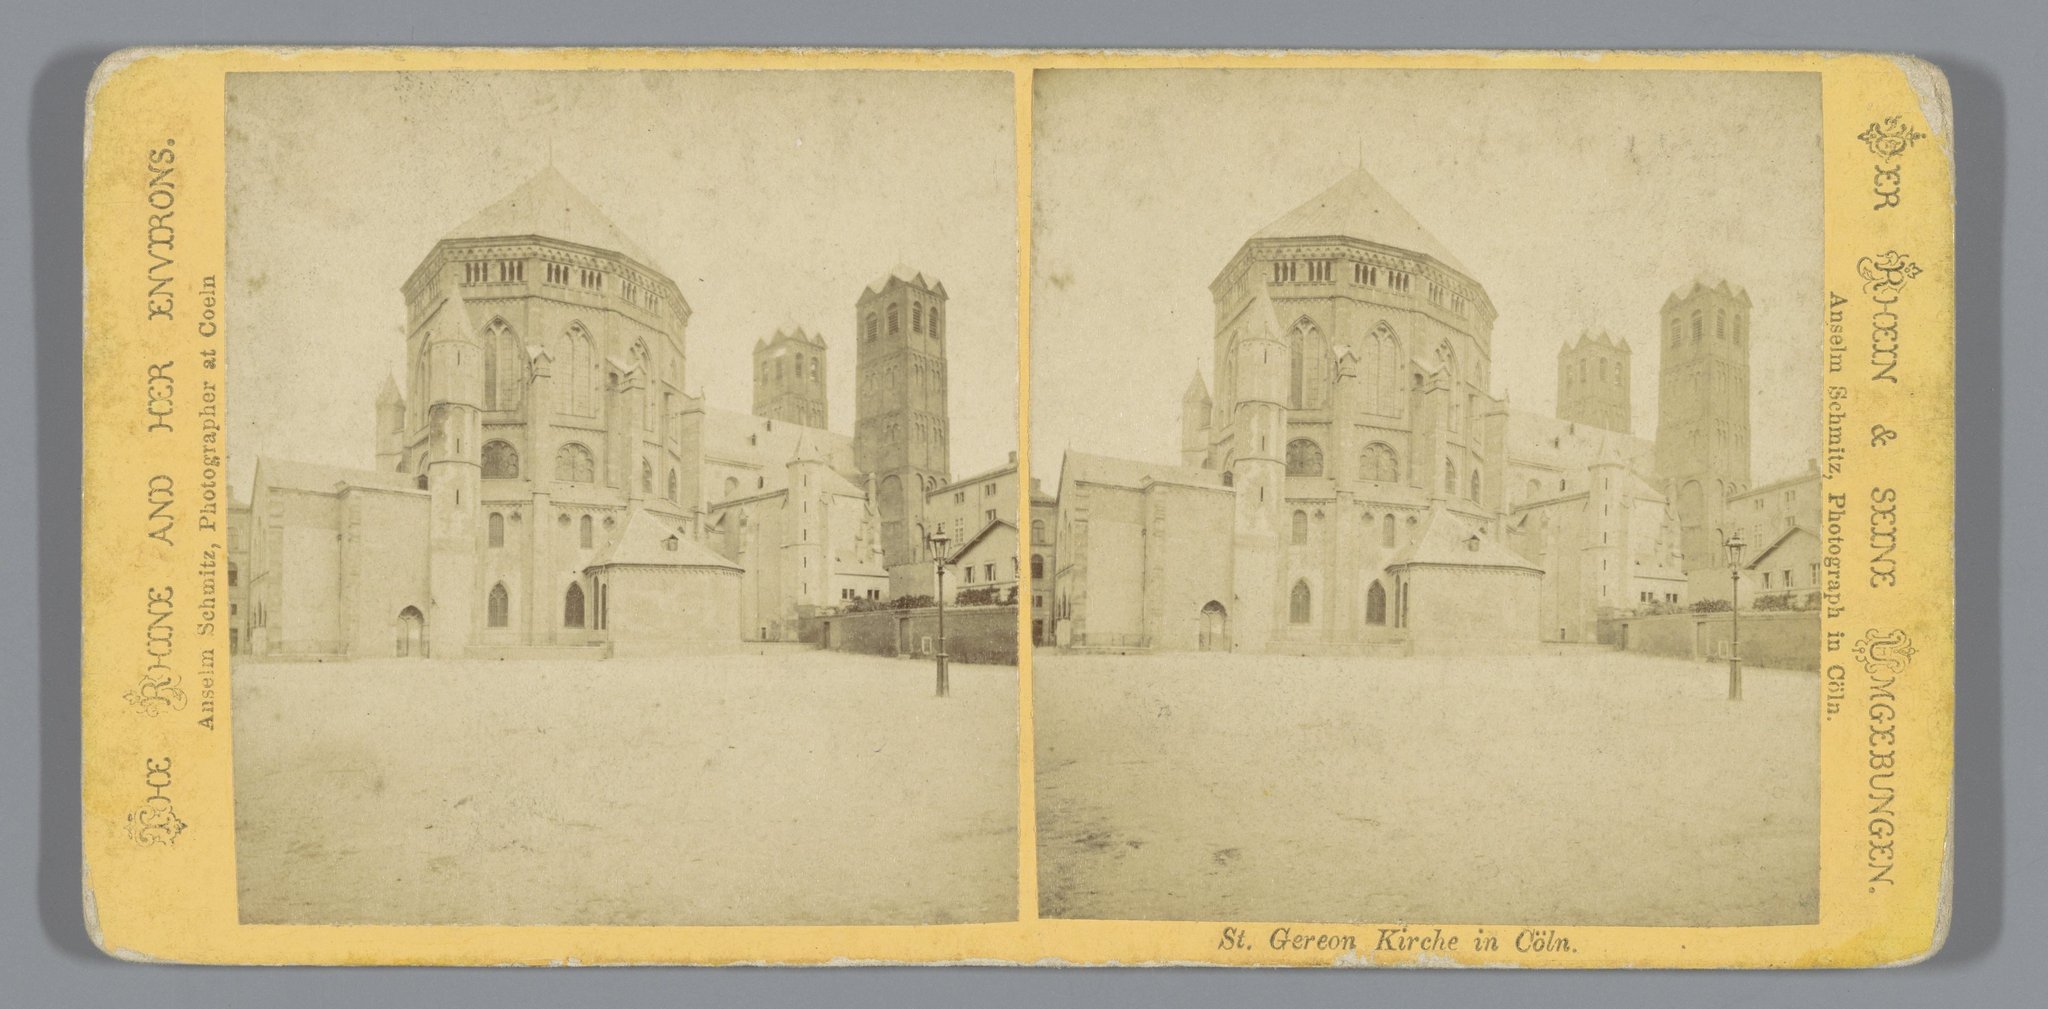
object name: stereograph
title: Der Rhein & Seine Umgebungen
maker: anselm schmitz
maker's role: publisher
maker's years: 1831-1903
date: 1860-1870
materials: cardboard, photographic support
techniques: albumen print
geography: cologne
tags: church (exterior), façade (of house or building)